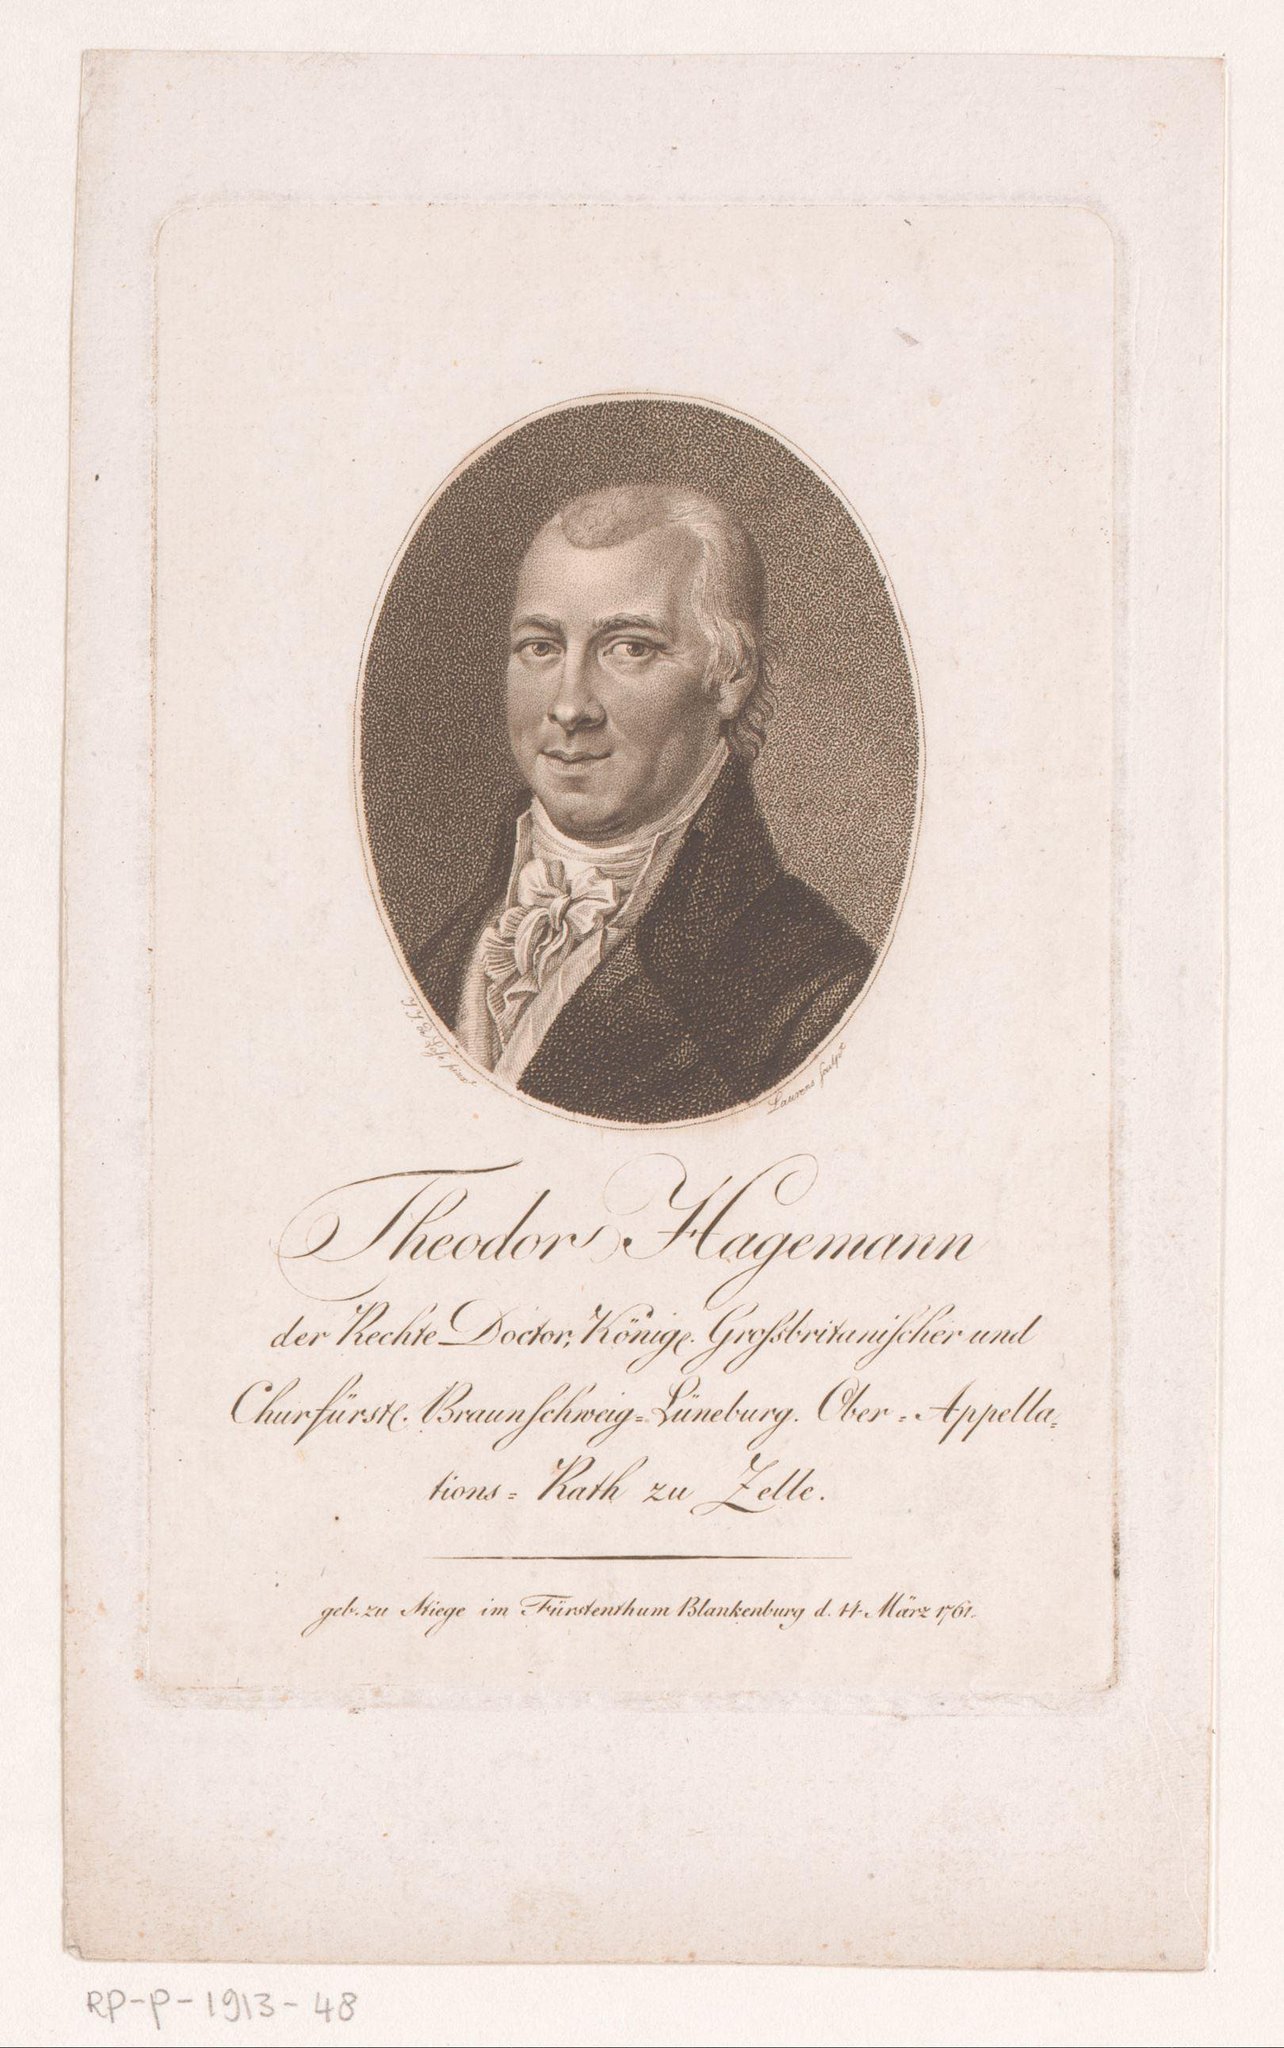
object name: print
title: Portret van Theodor Hagemann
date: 1780-1832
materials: paper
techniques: stippling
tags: further education (+ portrait of teacher, professor), historical persons, lawyer, attorney at law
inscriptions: collector's mark: Lugt 2228